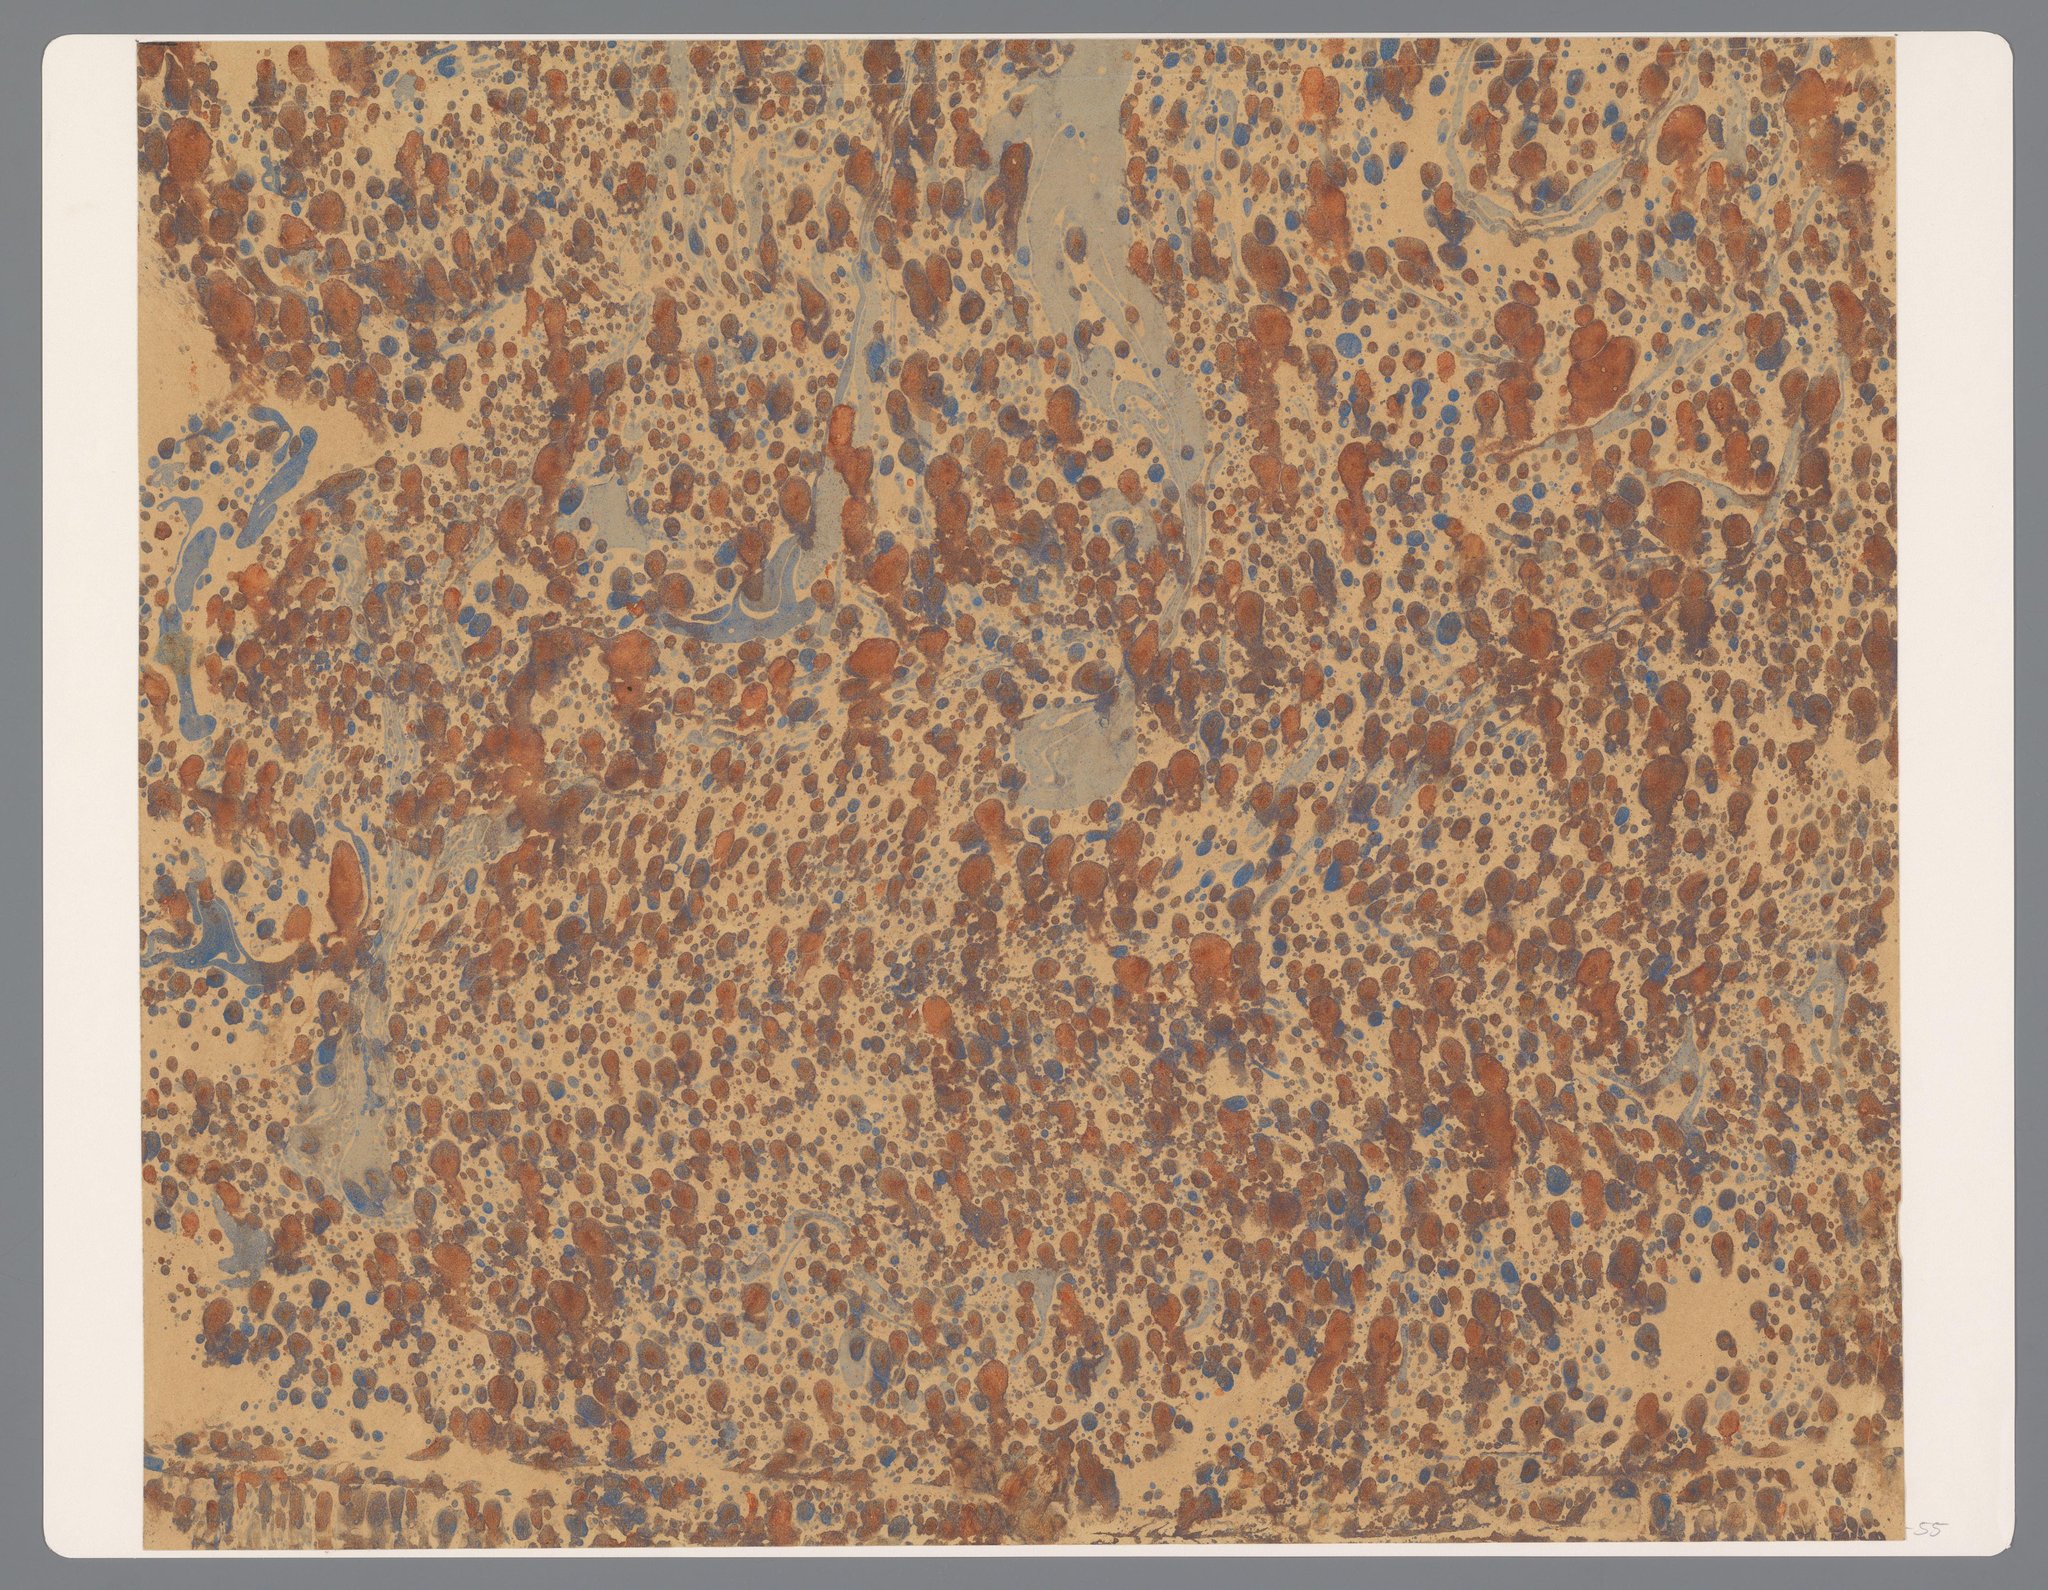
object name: marbled paper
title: Kiezelmarmer in bruin en blauw op geel papier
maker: Anonymous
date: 1800-1969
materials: paint, paper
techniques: marbling